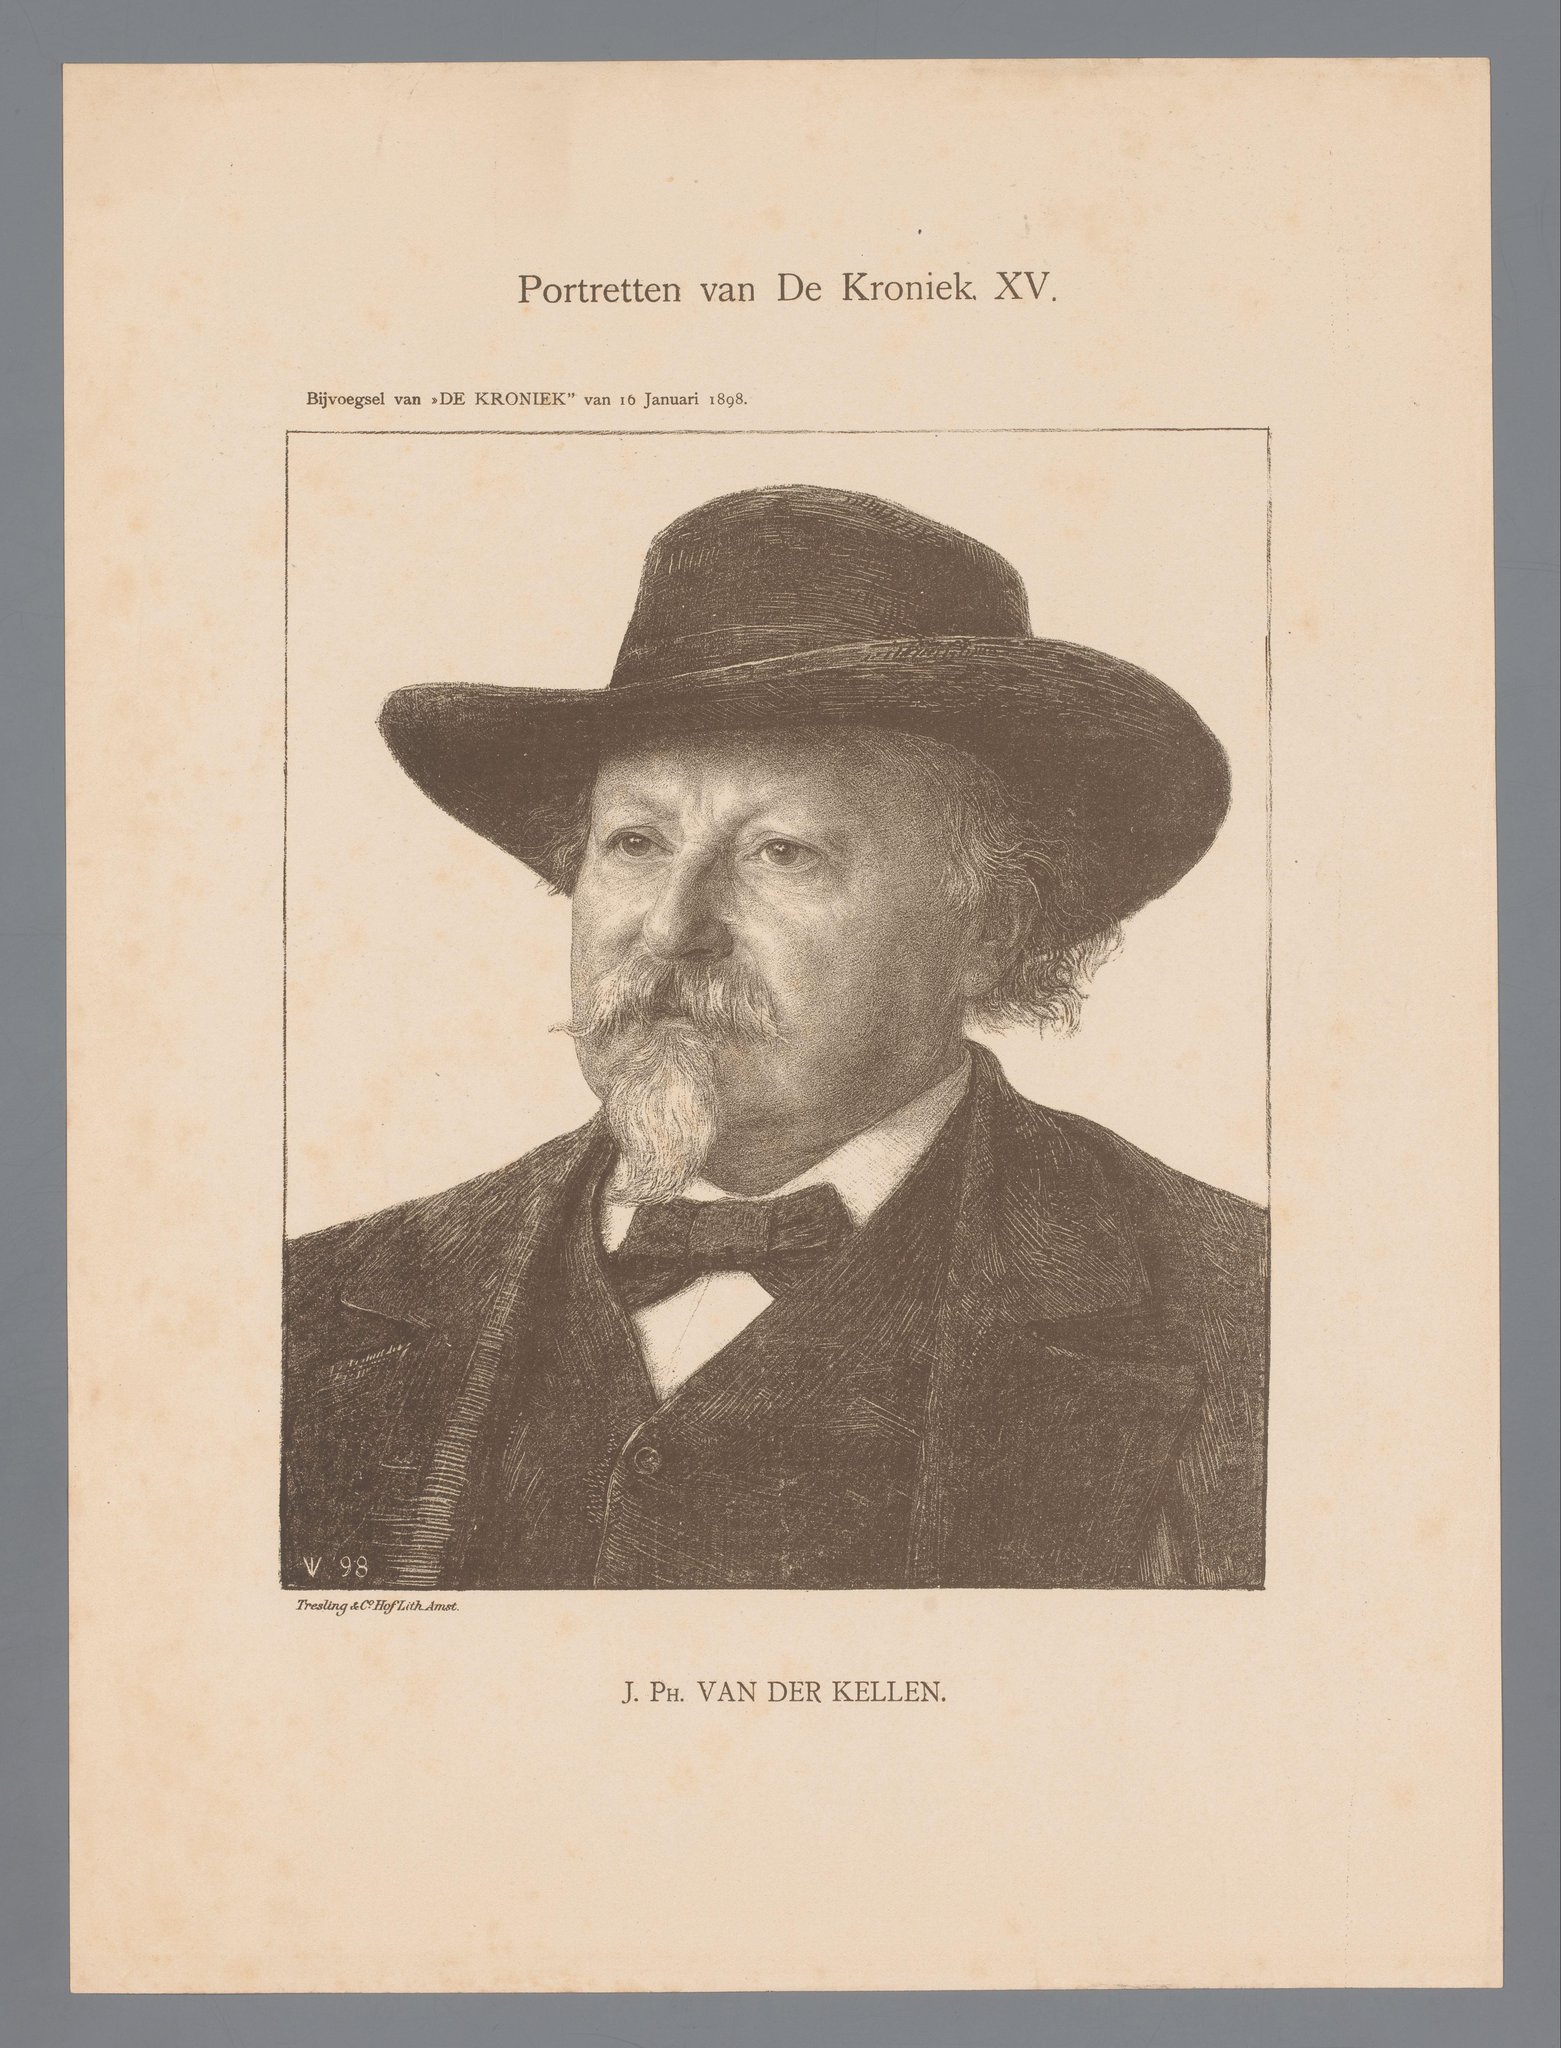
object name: print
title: J. Ph. van der Kellen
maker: jan veth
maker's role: designer, draughtsman, painter, print maker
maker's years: 1864-1925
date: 1898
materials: paper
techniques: lithograph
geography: amsterdam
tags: utrecht, draughtsman, johan philip van der kellen, historical persons, netherlands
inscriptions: date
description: Prent met titel en onderschrift, bijvoegsel bij 'De Kroniek'. Gesigneerd en gedateerd.